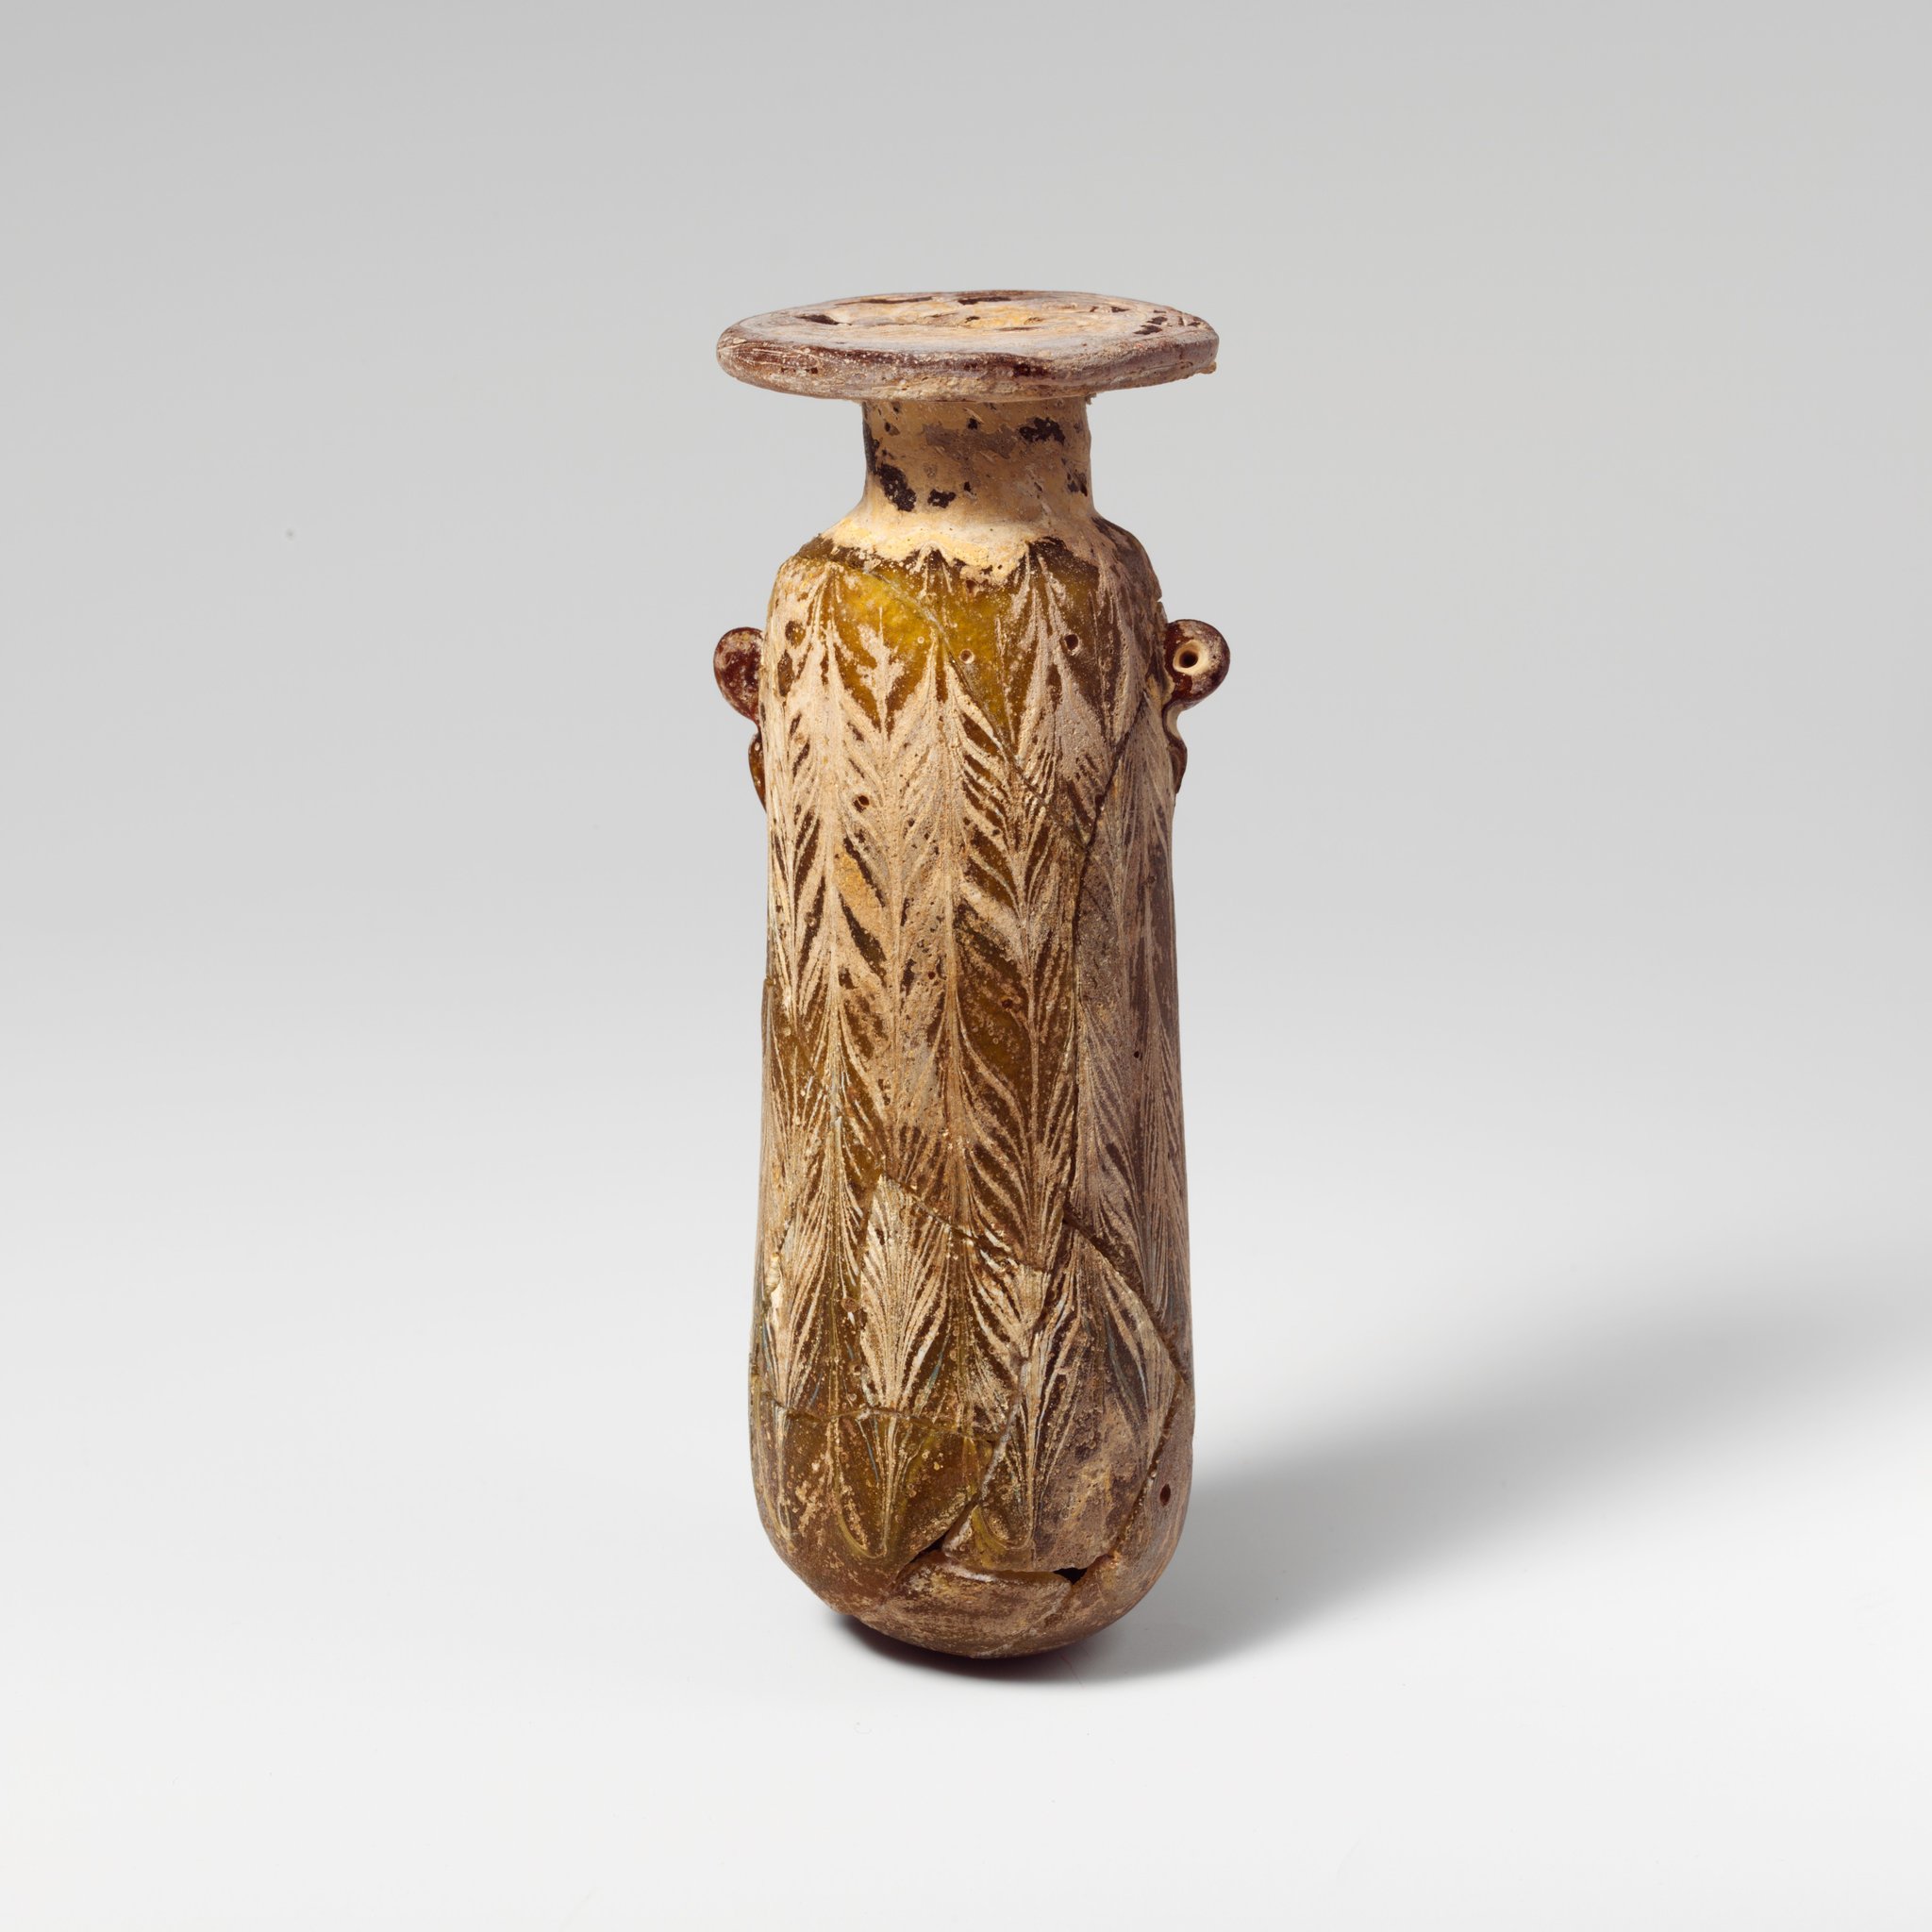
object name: alabastron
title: Glass alabastron (perfume bottle)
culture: greek or eastern mediterranean or italian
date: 367-268 BCE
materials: glass